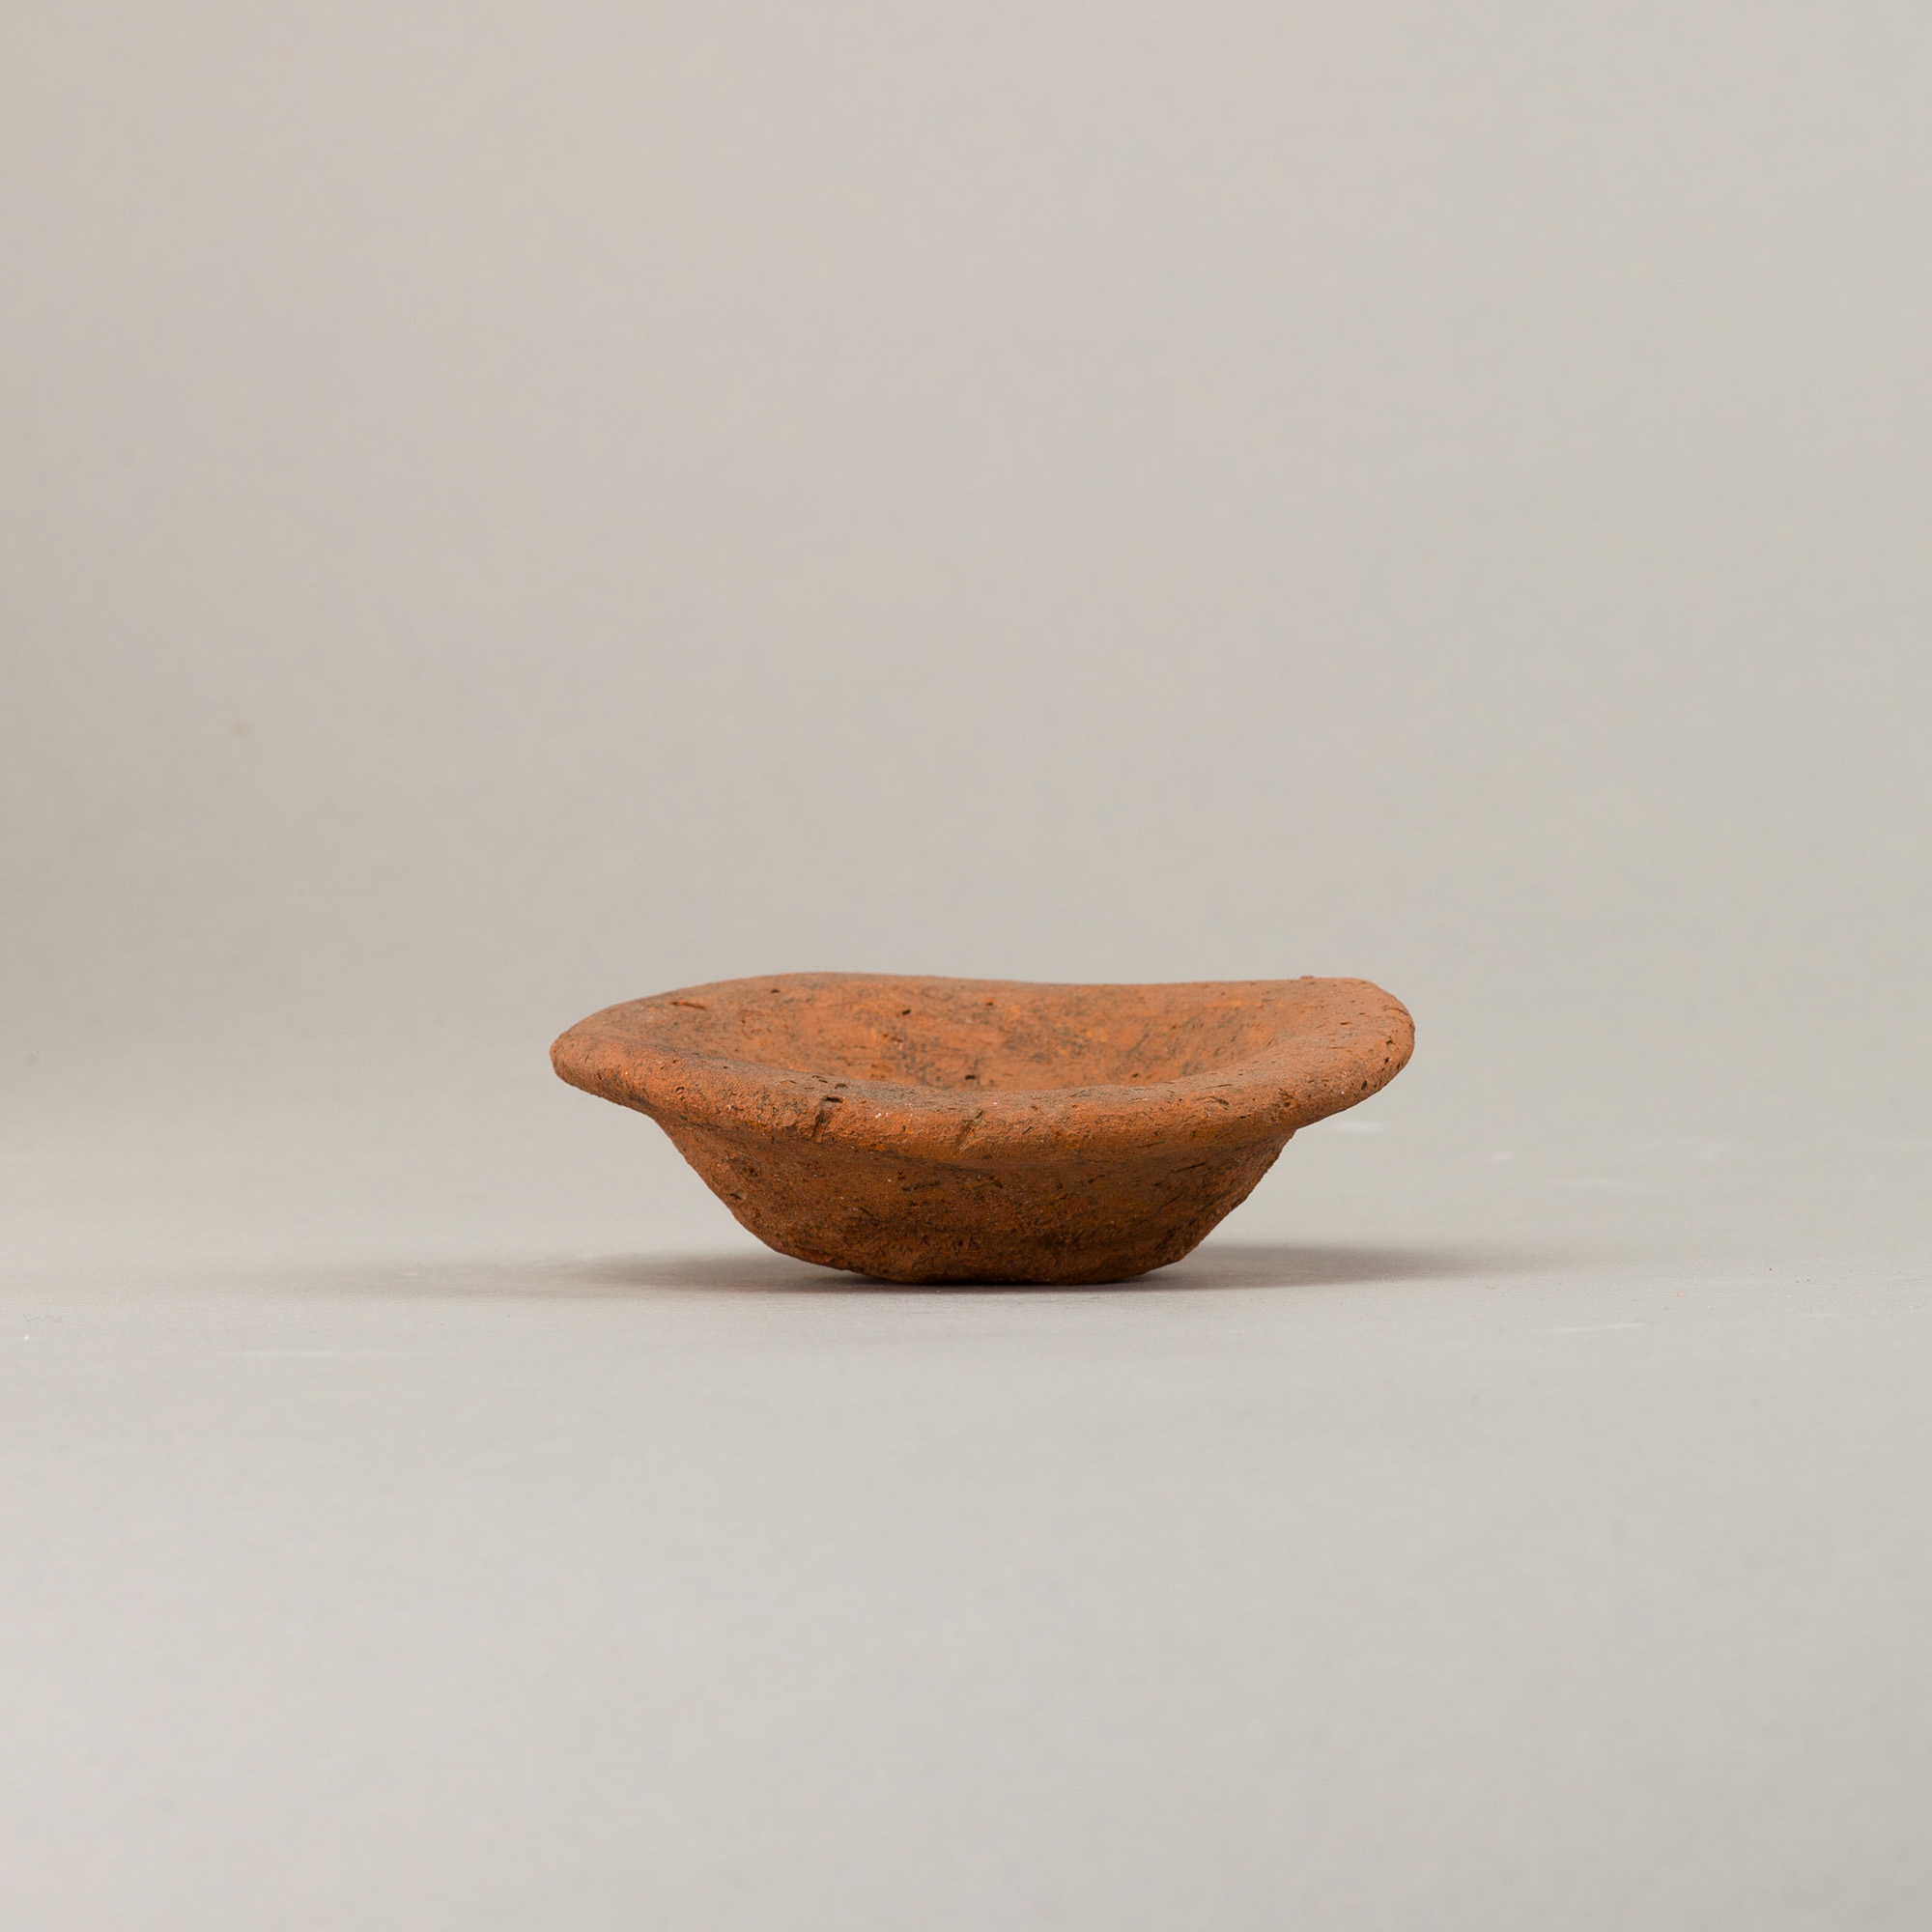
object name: dish saucer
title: Small saucer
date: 3100-2650 BCE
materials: pottery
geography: egypt